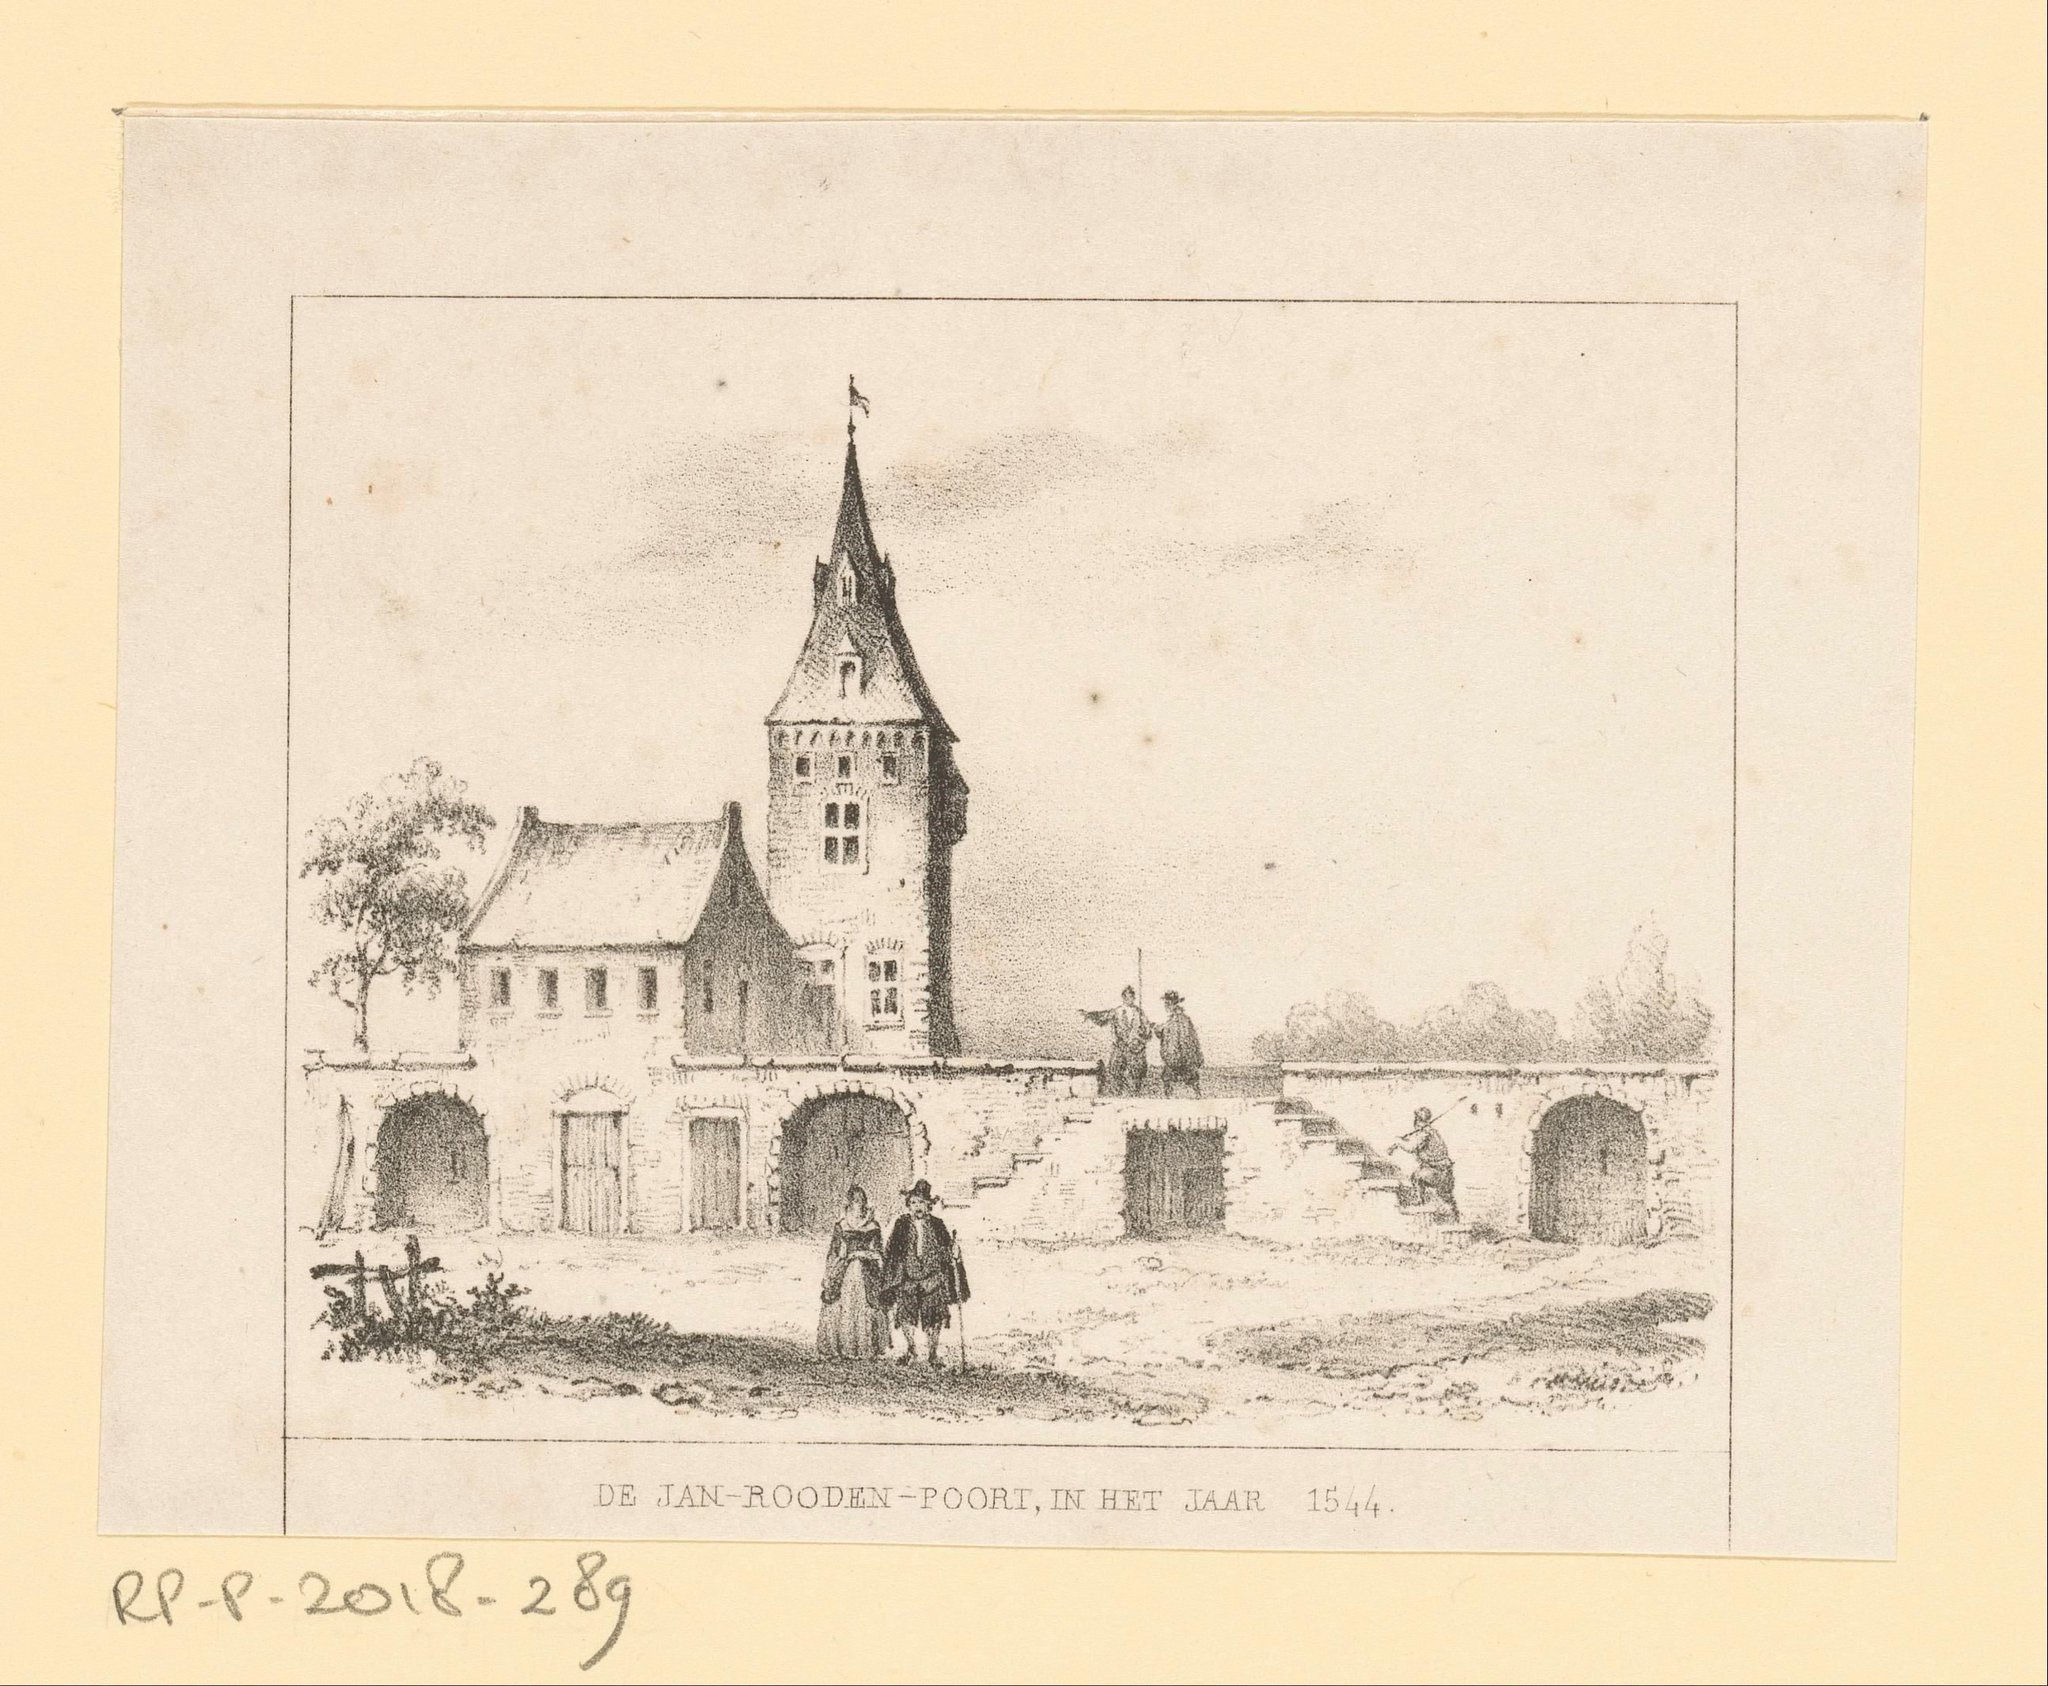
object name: book illustration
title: Gezicht op de Jan Roodenpoort te Amsterdam, 1544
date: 1844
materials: paper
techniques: lithograph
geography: amsterdam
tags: city-gate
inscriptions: collector's mark: Lugt 2228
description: Prent gebruikt in: Vijver, Cornelis van der. Geschiedkundige beschrijving der stad Amsterdam (…). 4 delen. Amsterdam: Gebroeders Diederichs, 1844-1848, dl. 1 (1844), p. 111. Zie ook RP-P-1914-4505.